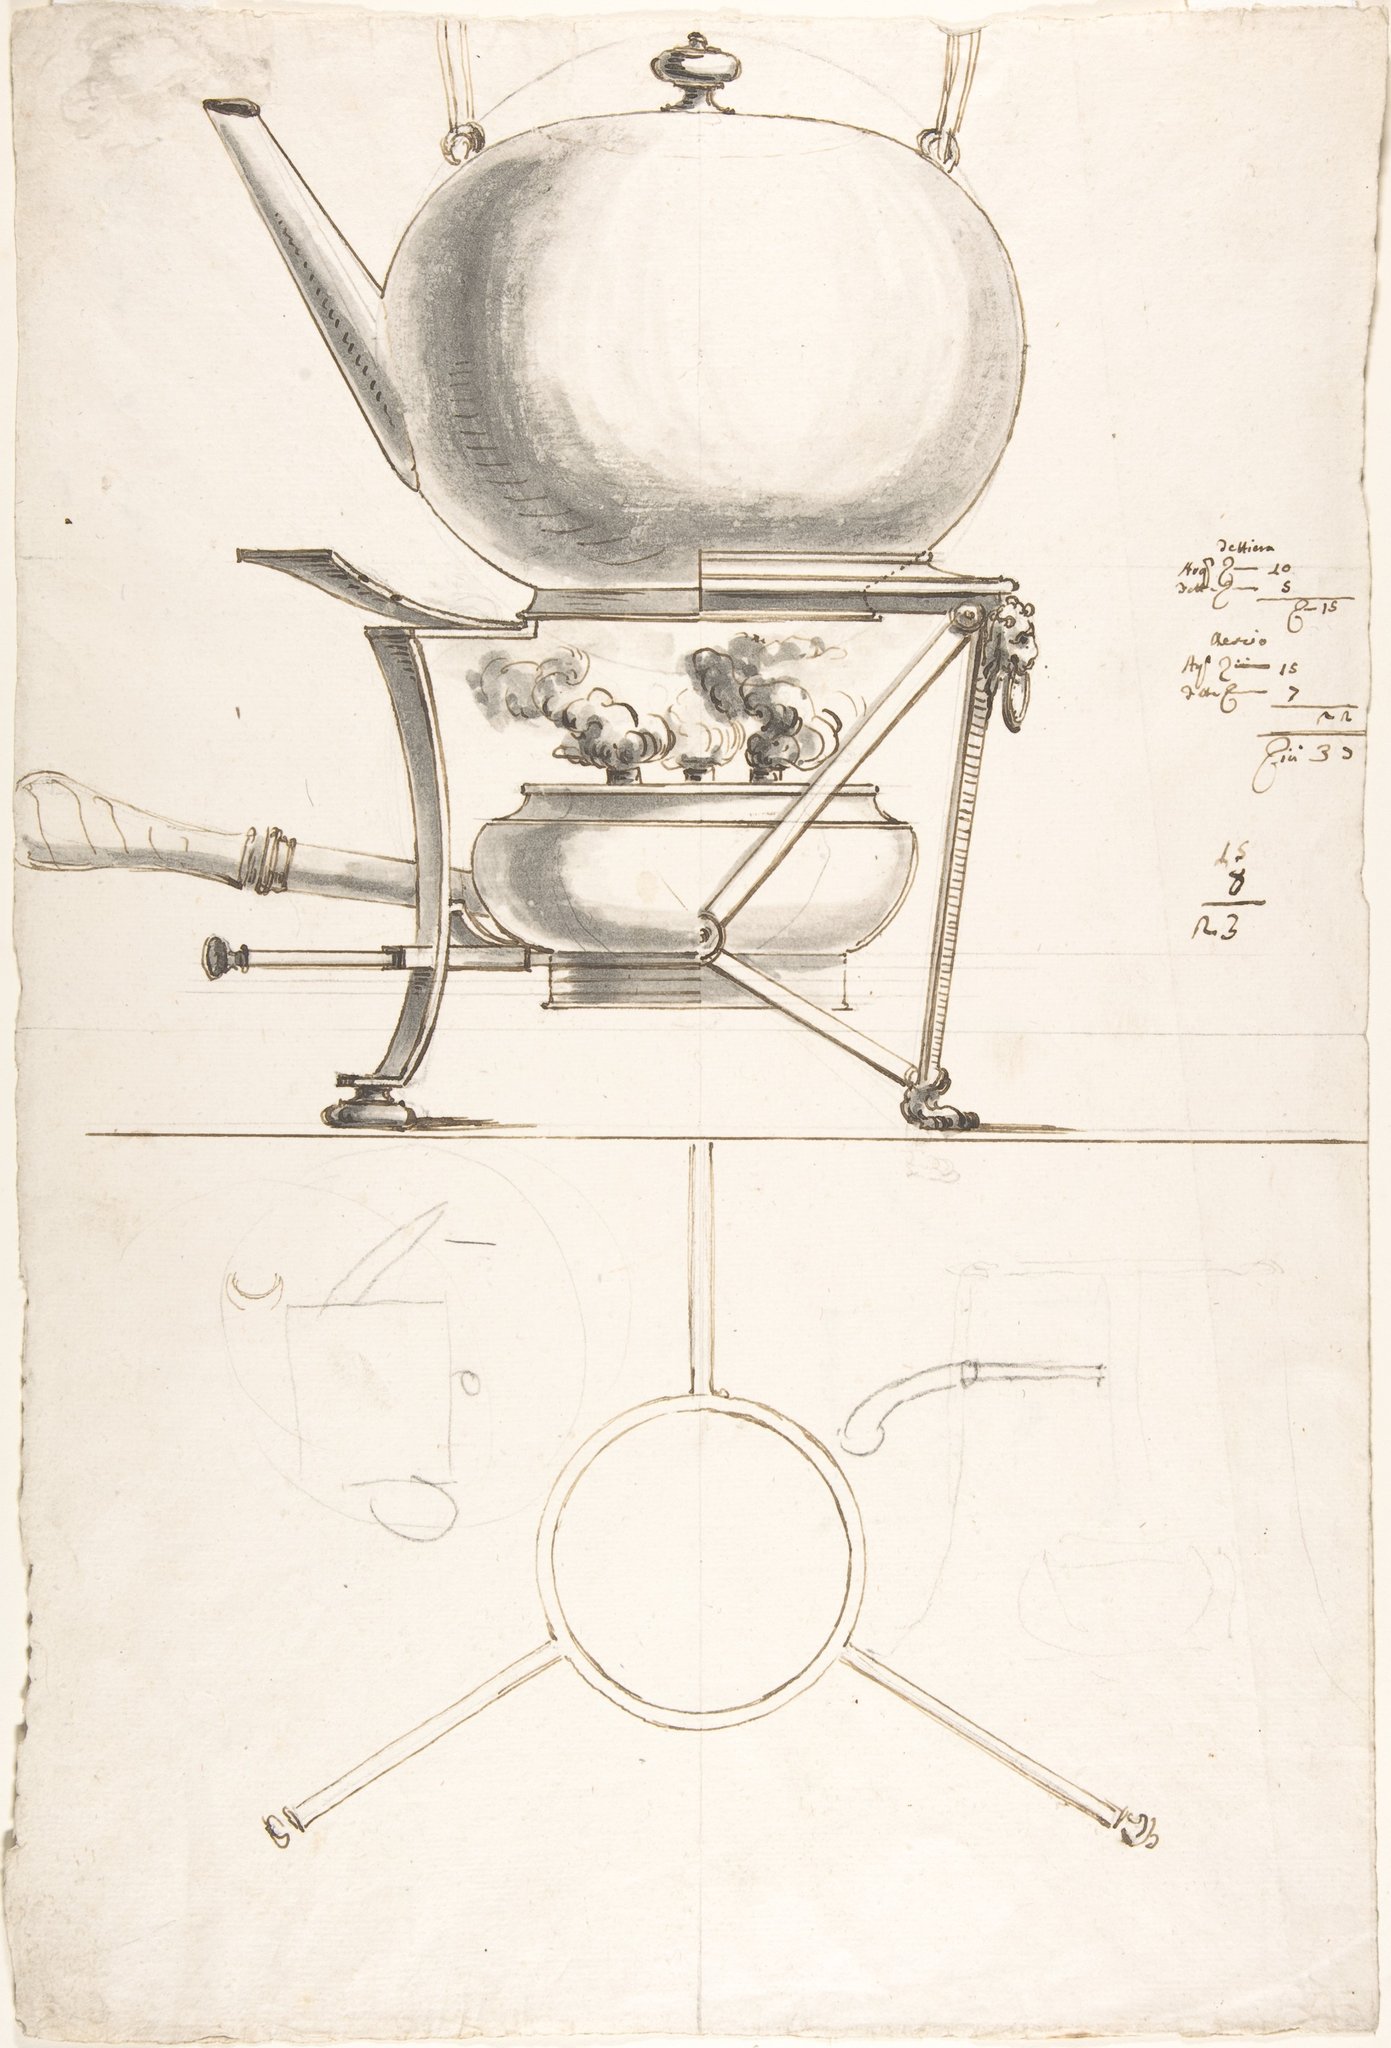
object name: drawing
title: Kettle with Spirit Burner and Stand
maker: anonymous, italian, 19th century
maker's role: artist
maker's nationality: italian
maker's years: 1800-1900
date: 1800-1900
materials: ink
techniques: pen, wash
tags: kettles